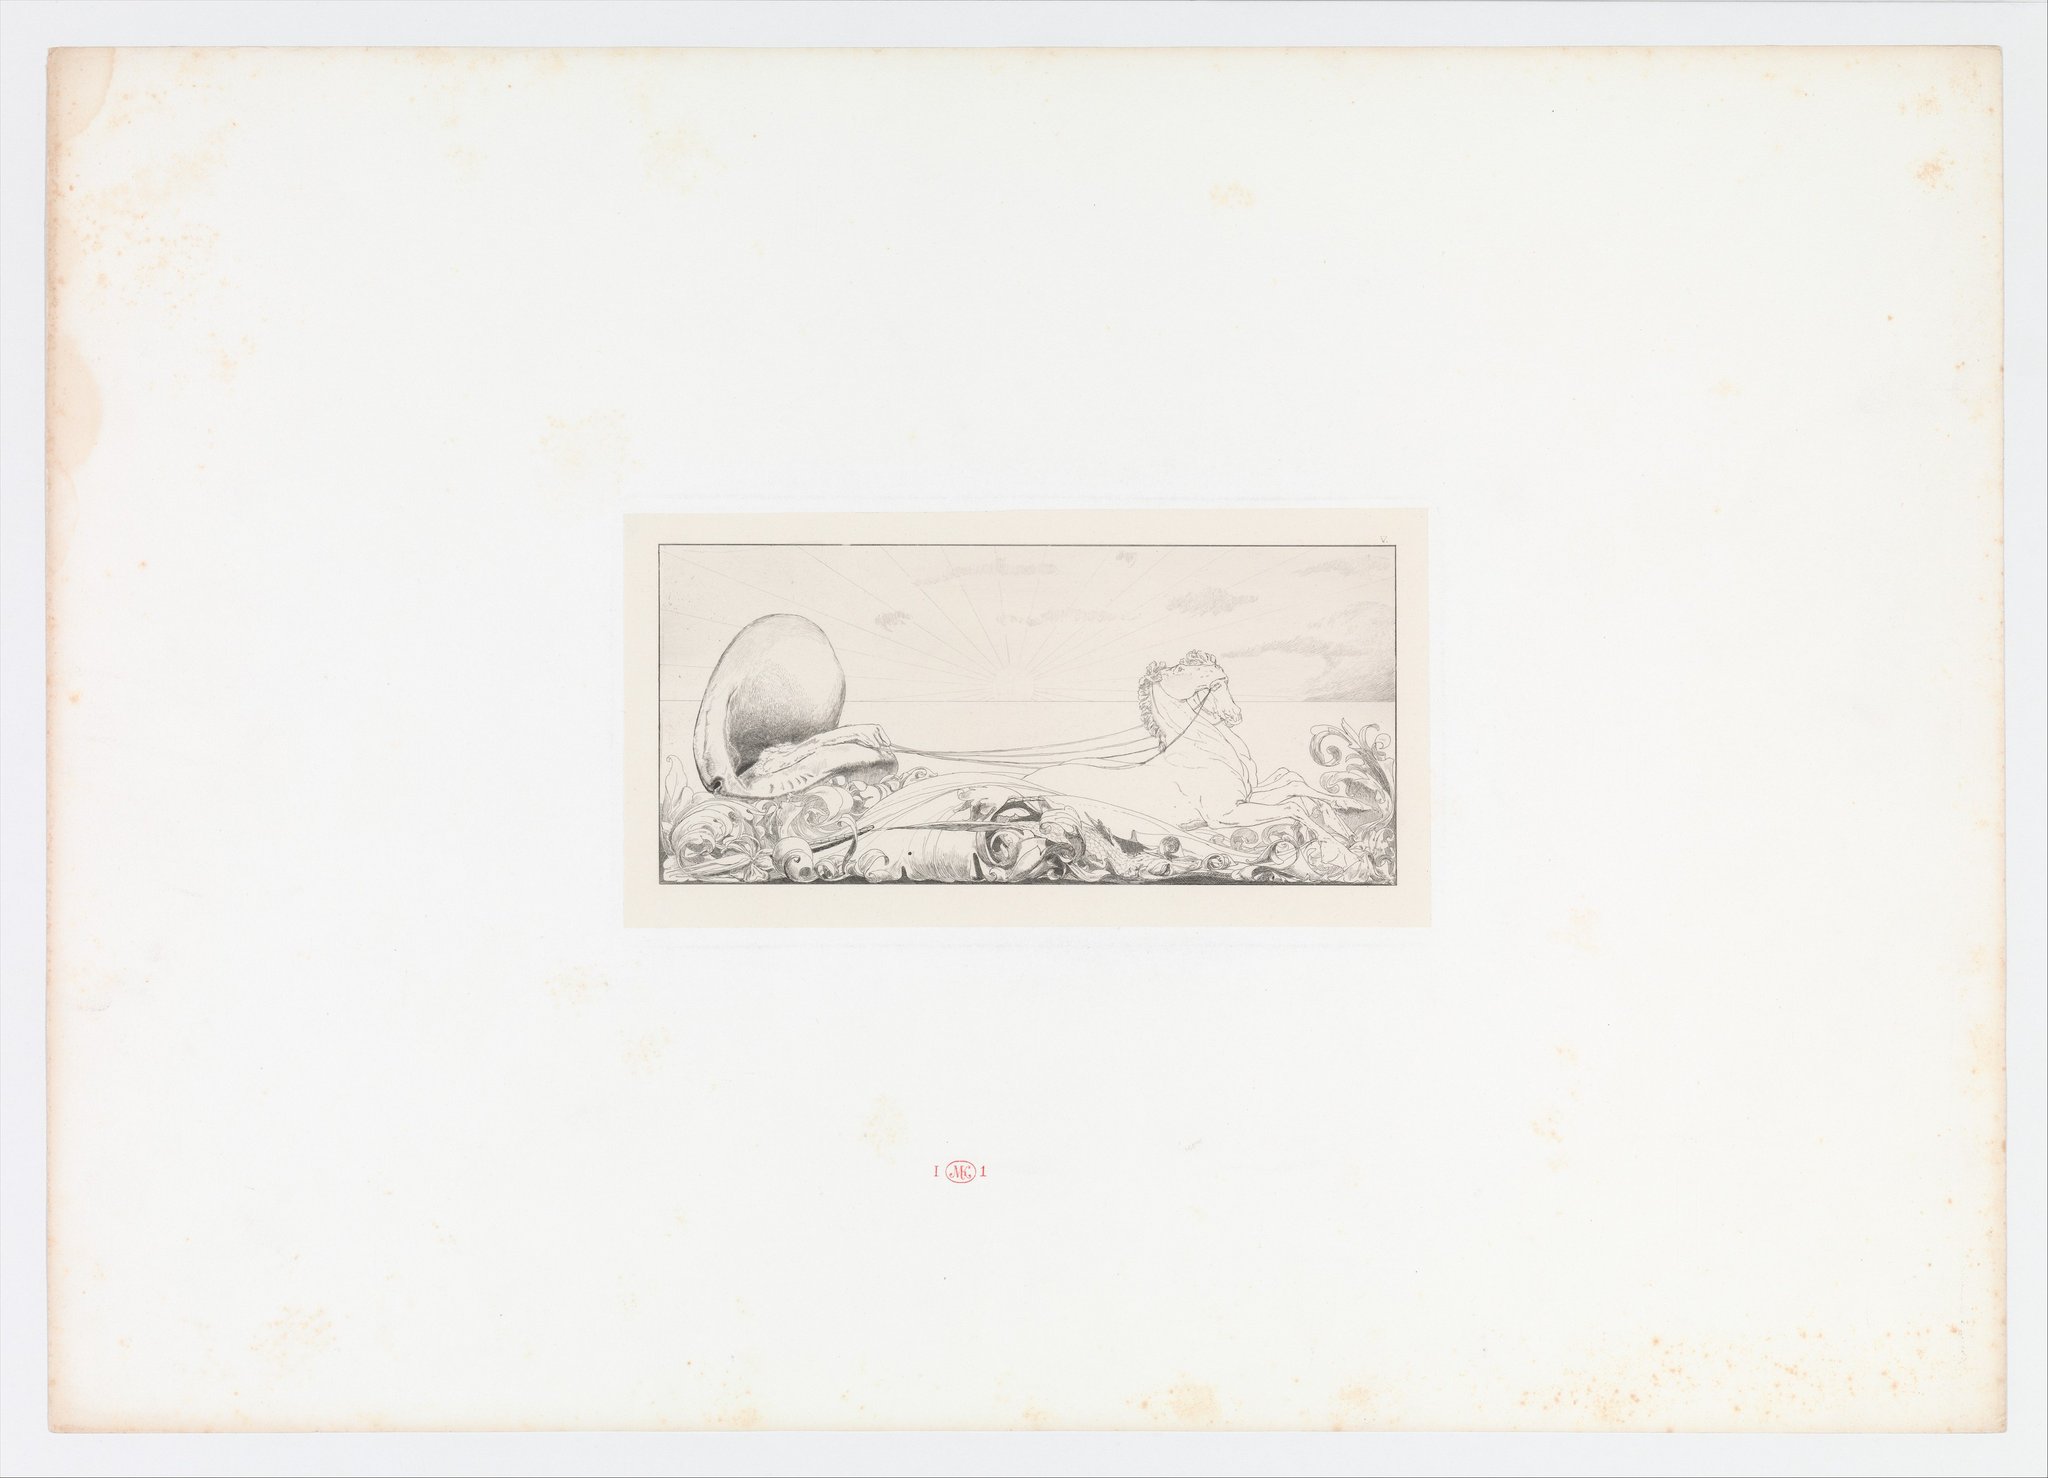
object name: print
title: Triumph from Ein Handschuh (A Glove). Cyclus von zehn Compositionen radirt. Rad. Opus VI, Plate V. First edition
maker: max klinger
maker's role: artist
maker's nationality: german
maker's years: 1857-1920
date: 1881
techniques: aquatint, printmaking, drypoint, etching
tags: horses,chariots